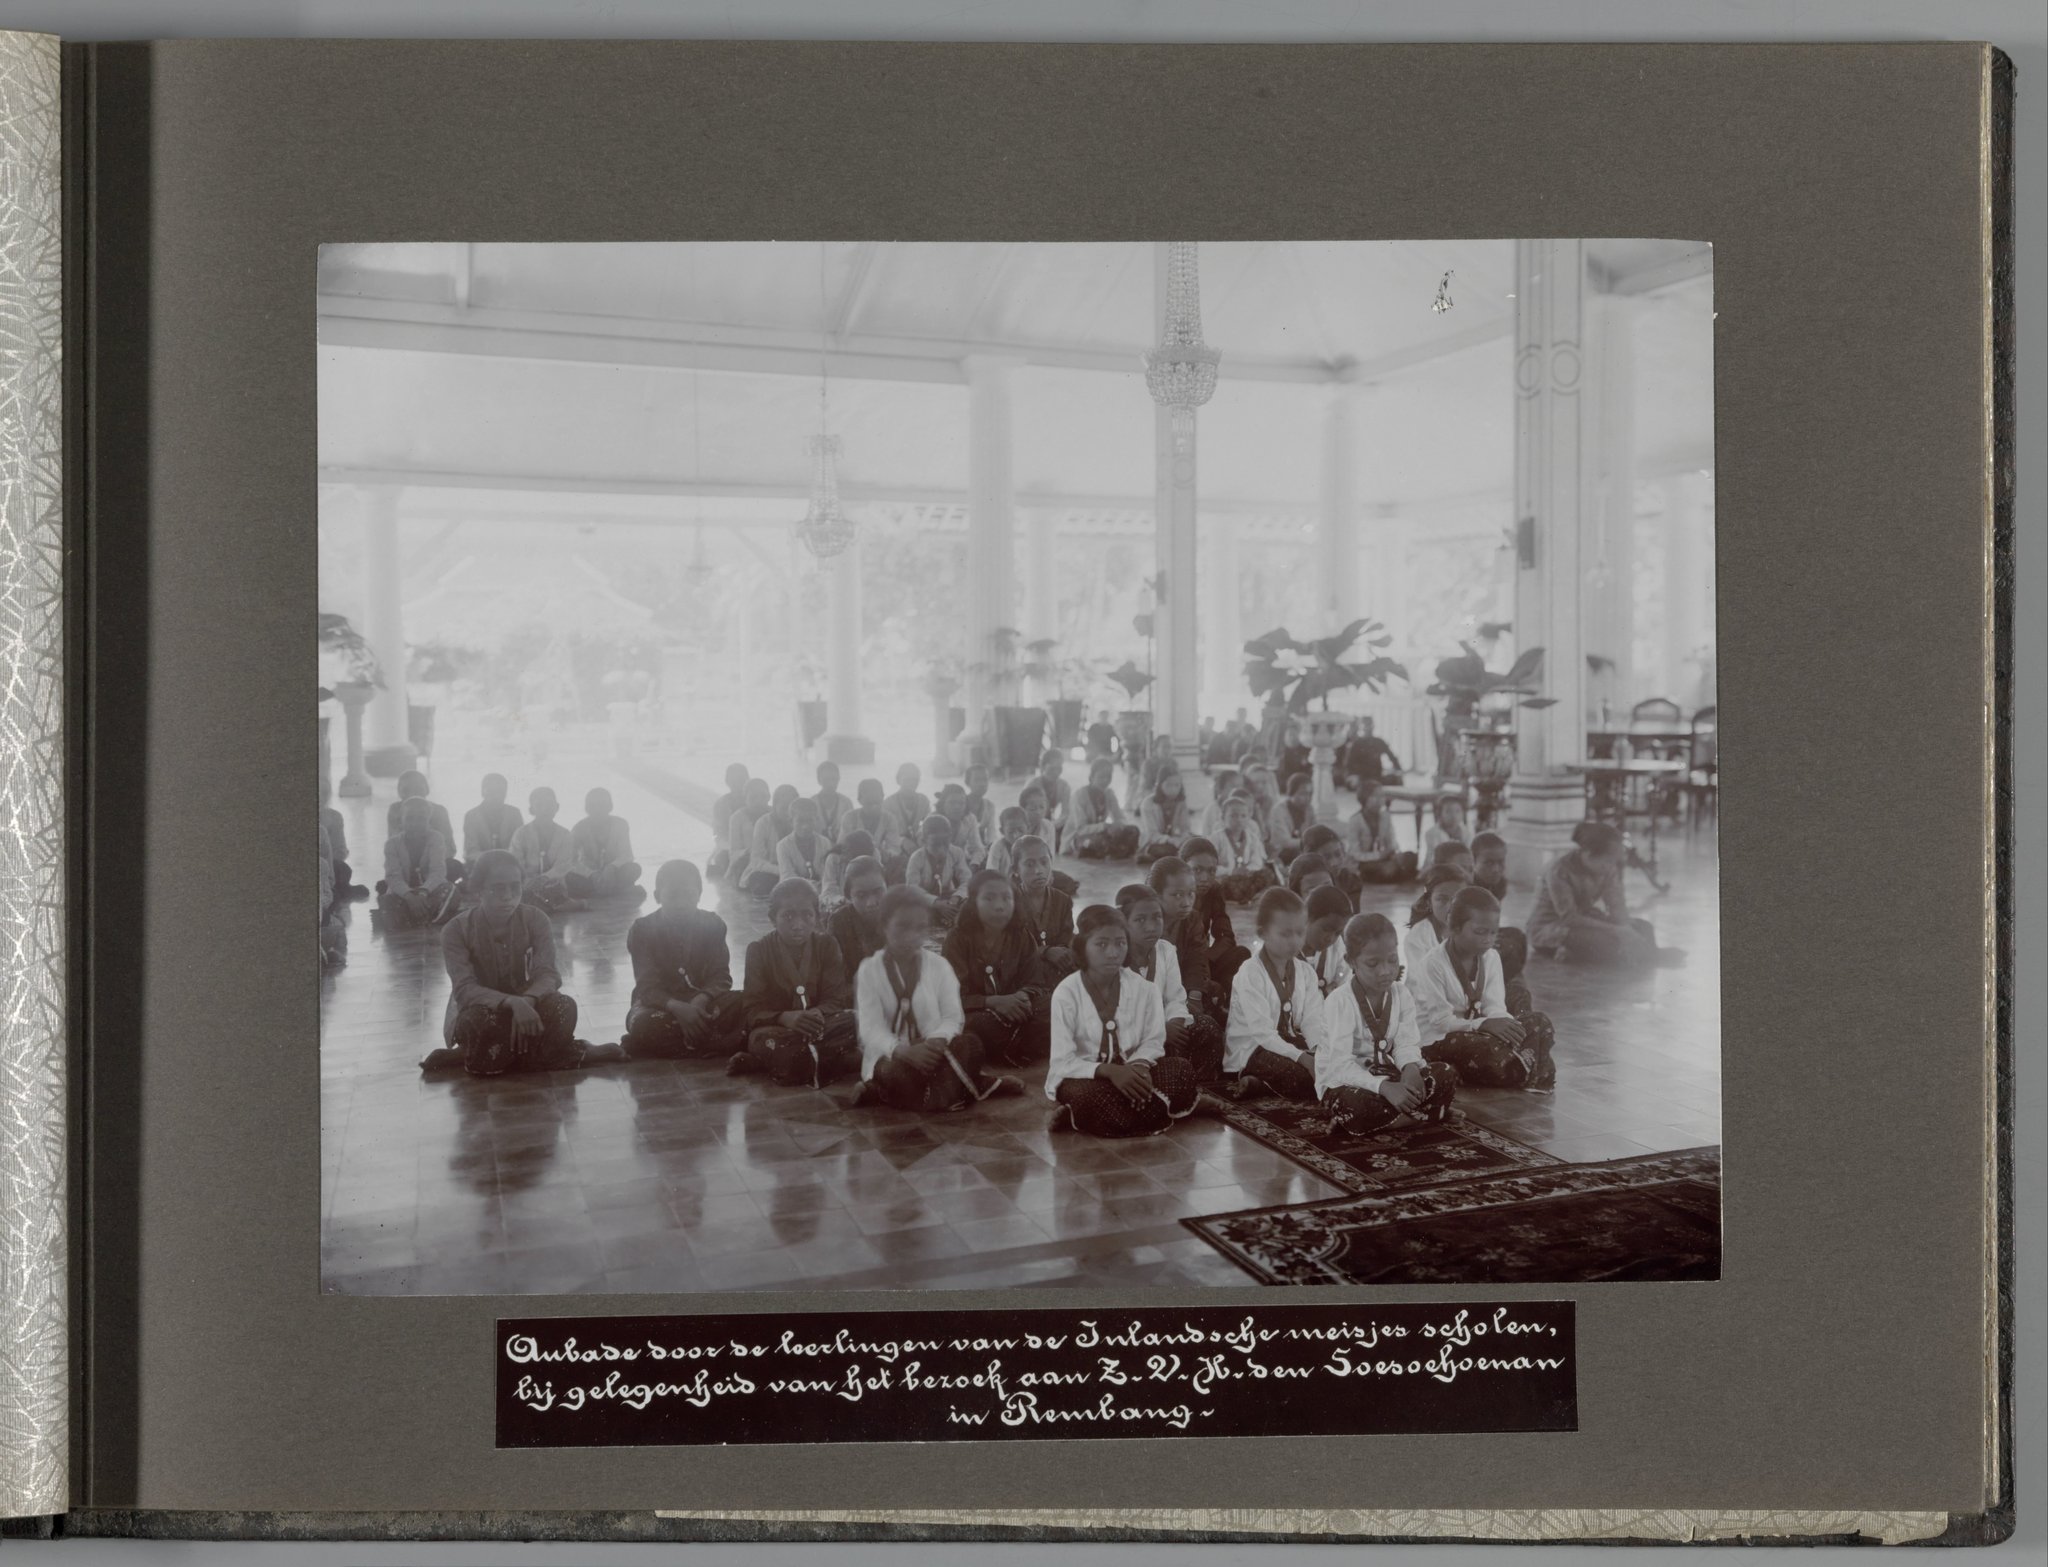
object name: photograph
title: Aubade door de leerlingen van de Inlandsche meisjes scholen, by gelegenheid van het bezoek aan Z.V.H. den Soesoehoenan in Rembang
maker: Anonymous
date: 1933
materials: photographic support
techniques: photography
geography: rembang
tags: royal household; courtiers, retinue, train, choir, colonial government, rembang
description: Aubade door de leerlingen van de 'inlandse meisjesscholen', ter gelegenheid van het bezoek van de Soesoehoenan aan Rembang. Foto in het fotoalbum met 14 foto's ter herinnering aan het bezoek van de Soesoehoenan Pakoe Boewono X van Soerakarta Hadiningrat, aan Cepu (Tjepoe) en omgeving op 14 juni 1933.